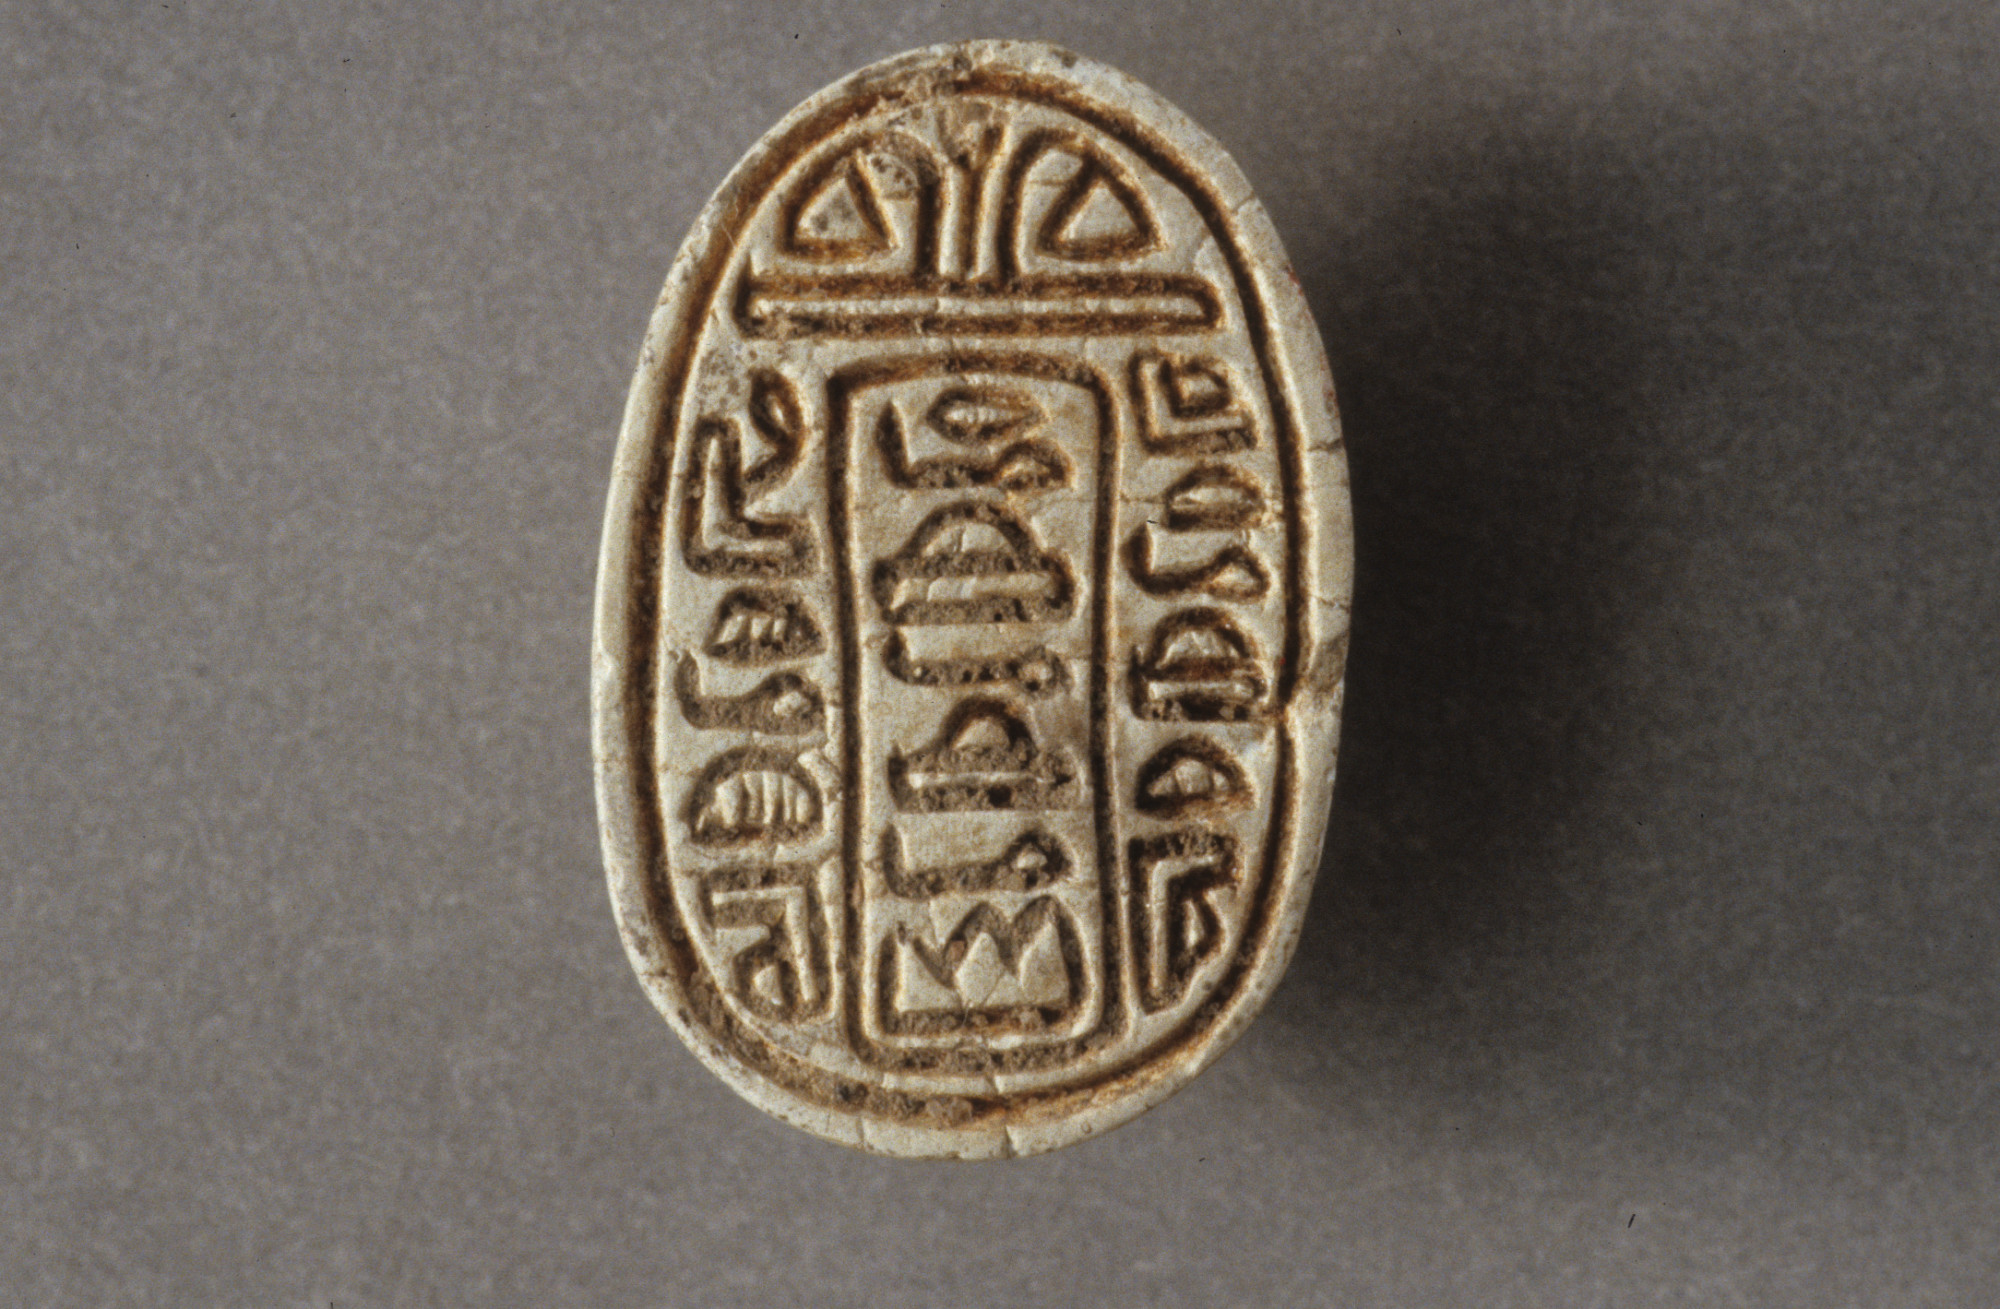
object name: scarab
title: Canaanite Scarab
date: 1648-1540 BCE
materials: stone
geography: eastern delta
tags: scarabs